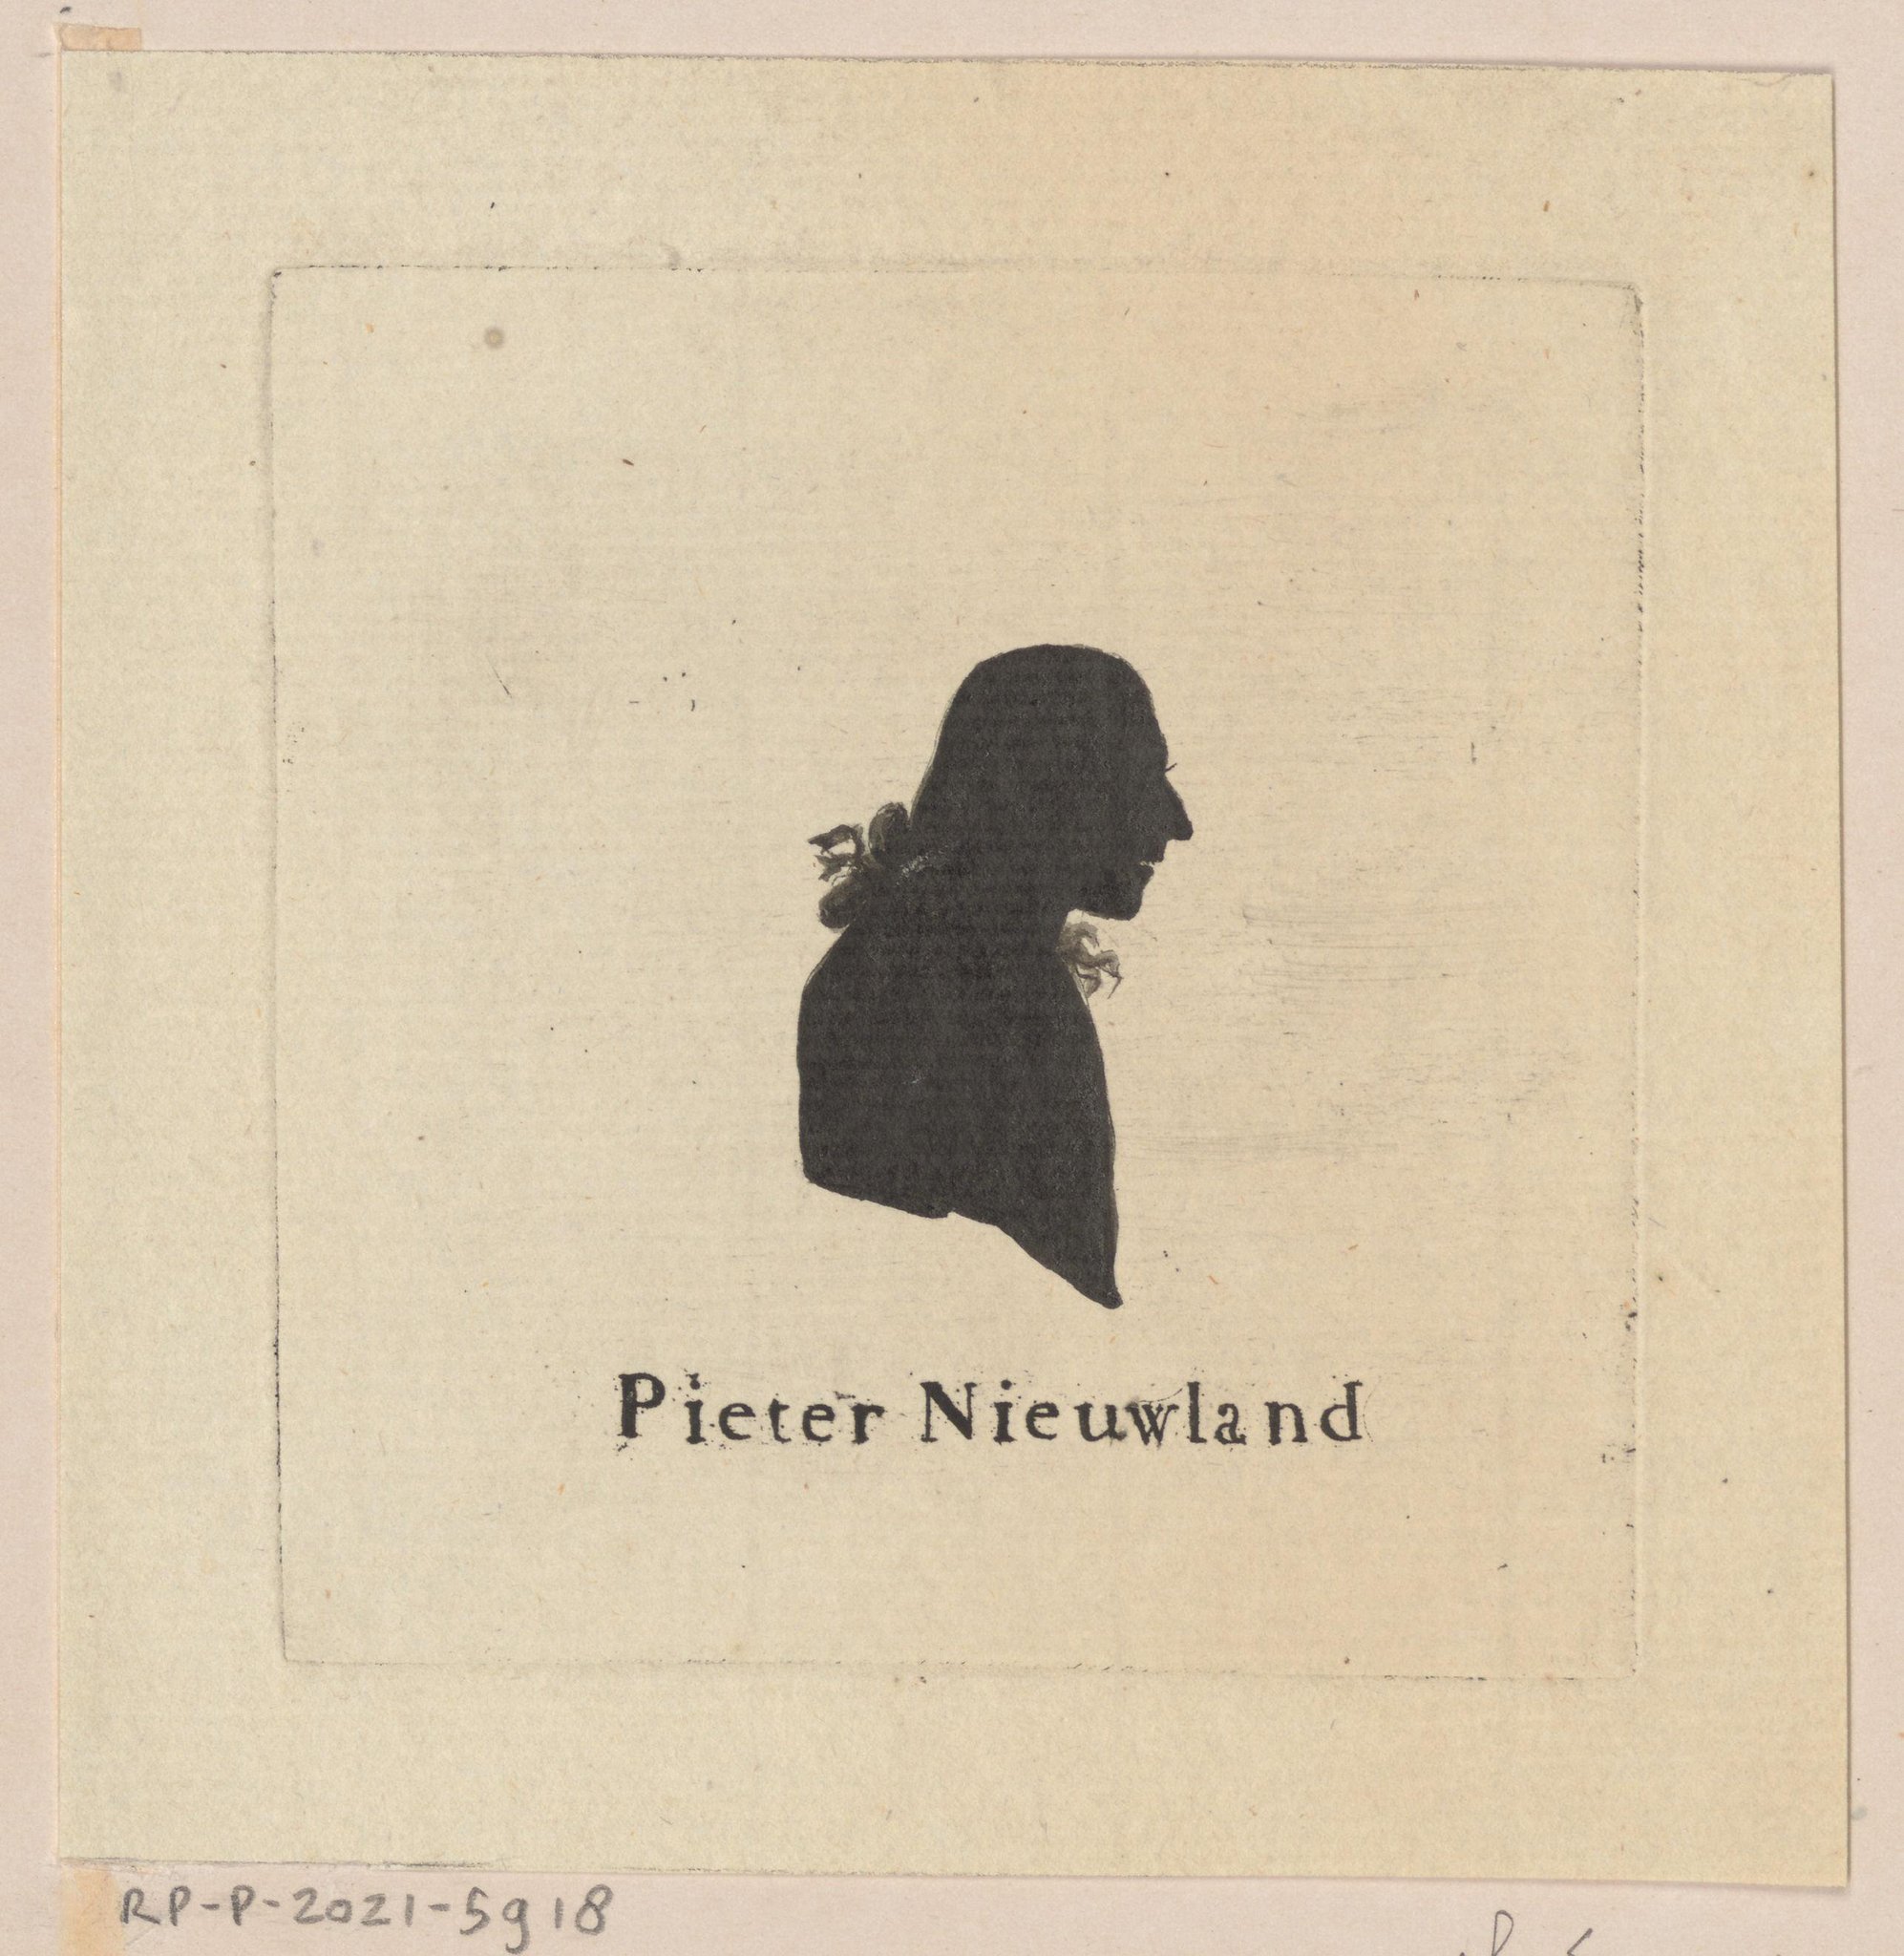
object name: print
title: Portret van Pieter Nieuwland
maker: Anonymous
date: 1789-1825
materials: ink, paper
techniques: brush, etching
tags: historical persons, professor